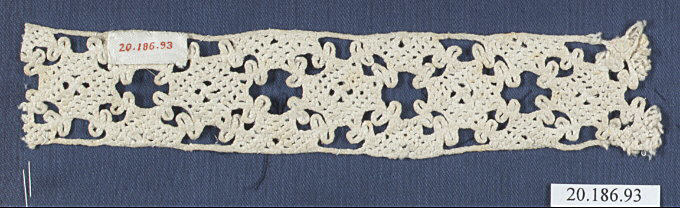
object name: insertion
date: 1501-1600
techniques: lace